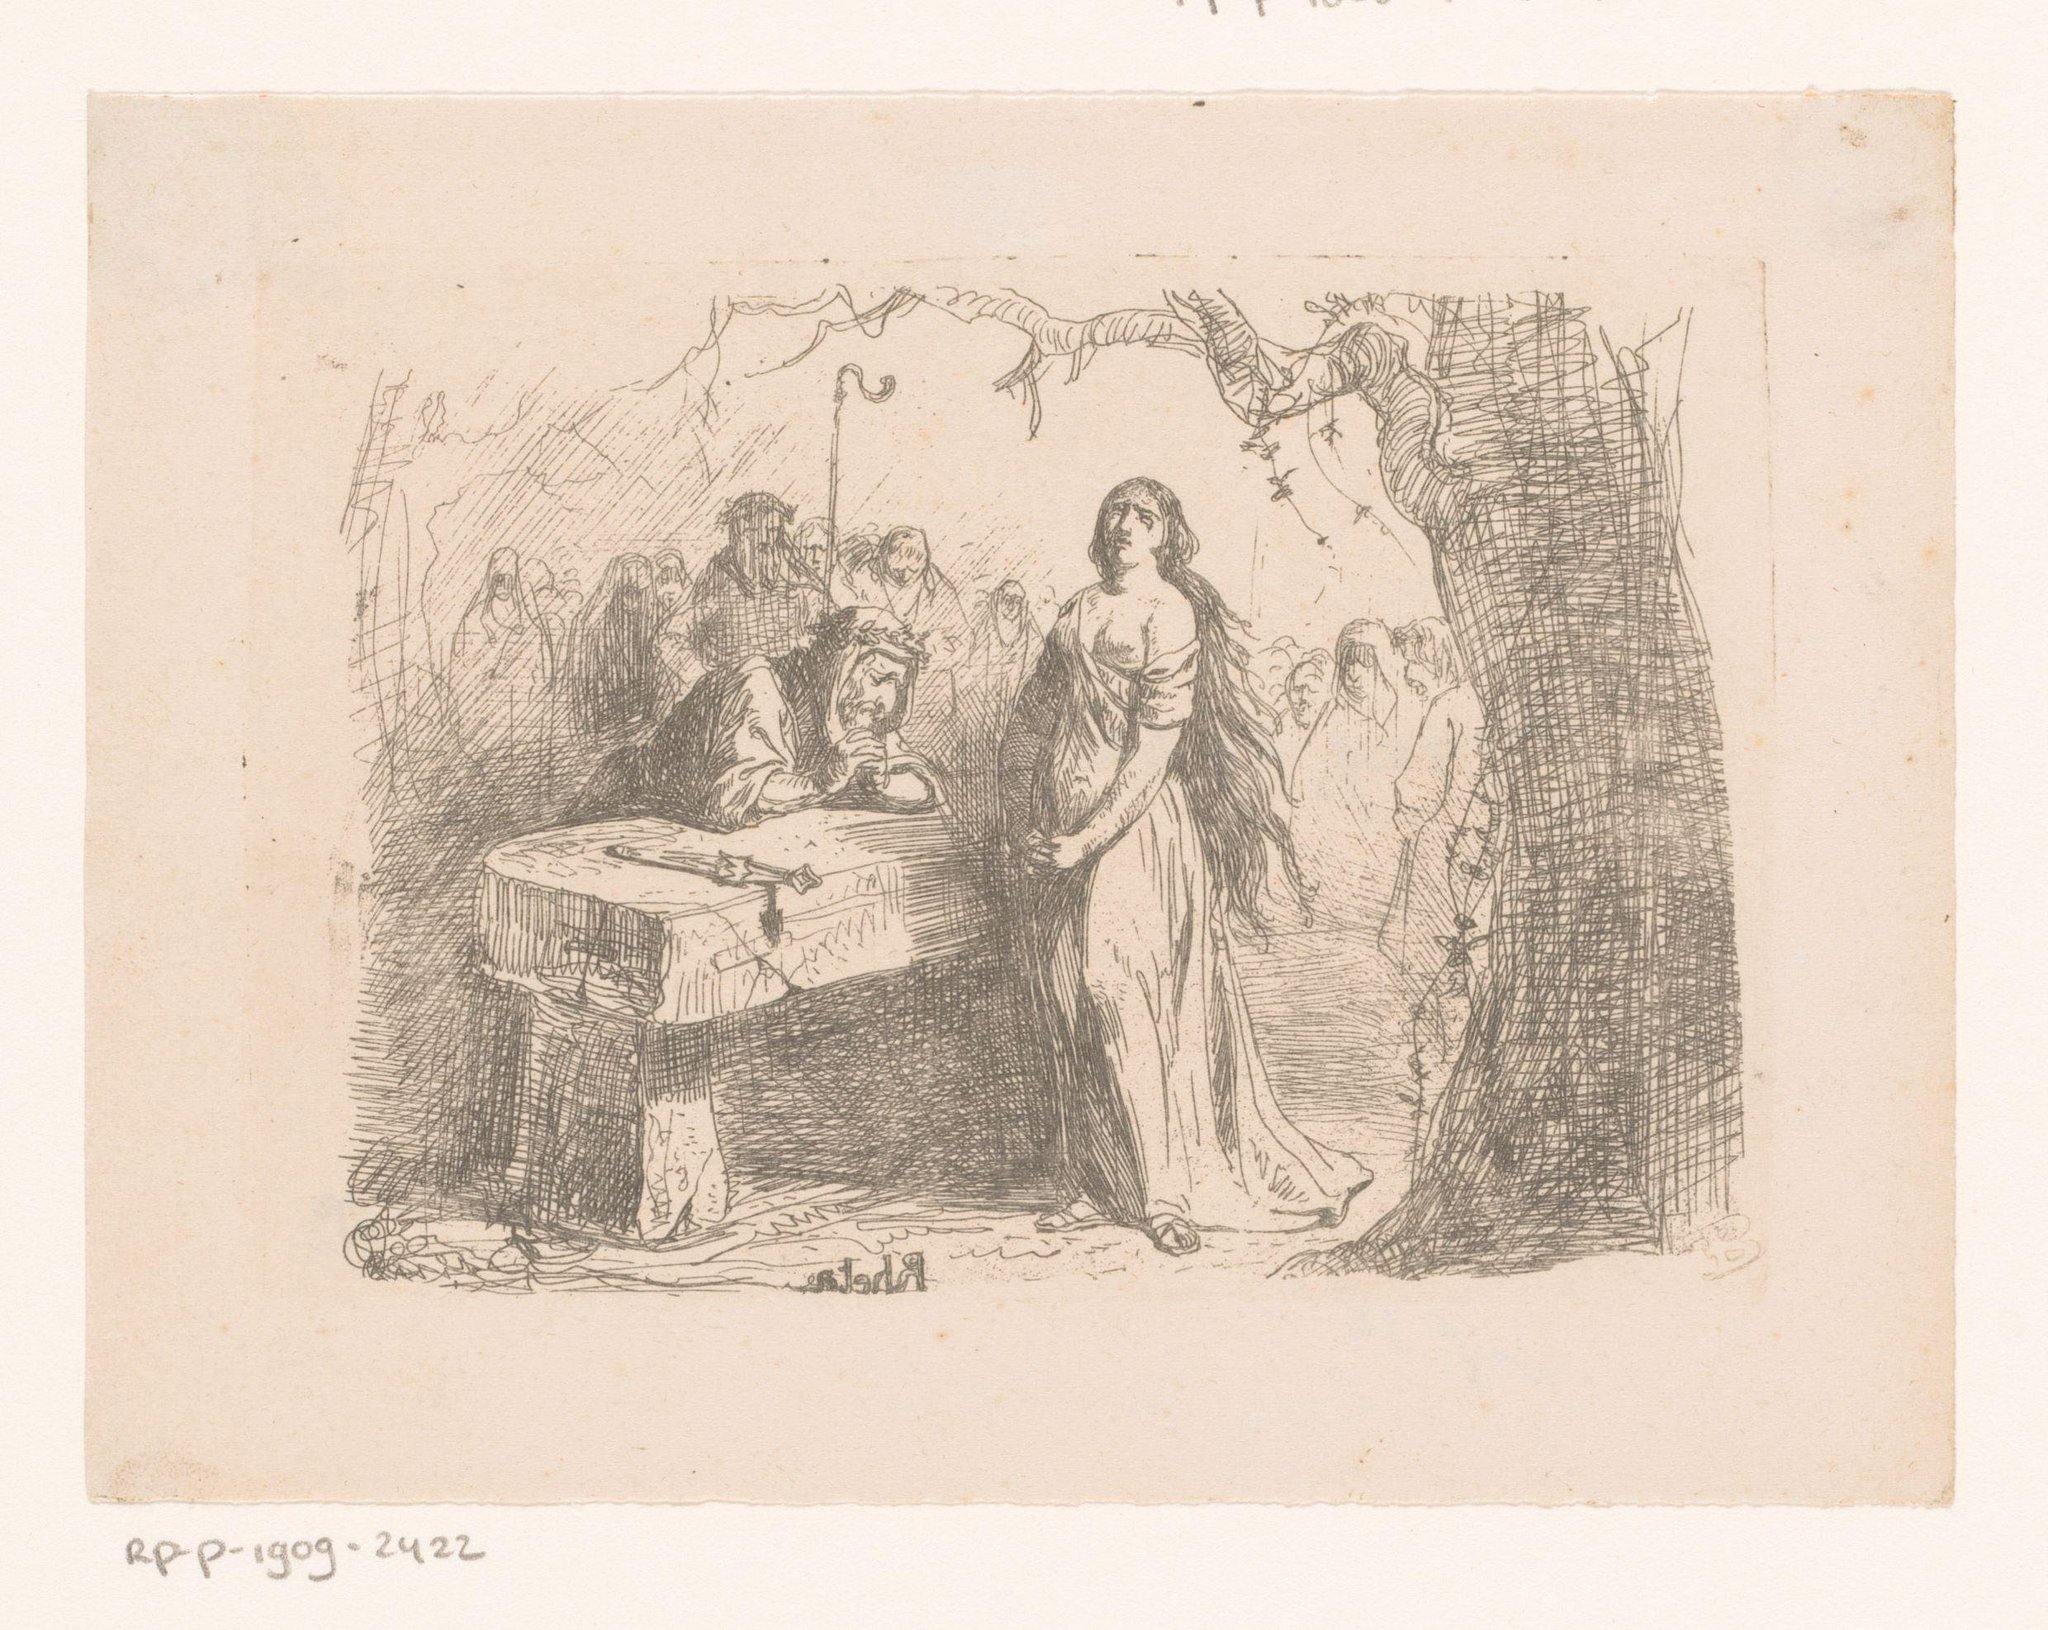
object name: print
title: Jonge vrouw te midden van druïden bij een offertafel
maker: eugène françois de block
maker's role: draughtsman, painter, print maker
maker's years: 1812-1893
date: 1842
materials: paper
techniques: printmaking, etching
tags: adult woman, human sacrifice ~ non-christian religions, druid (celtic religious functionary)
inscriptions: collector's mark: Lugt 2228, collector's mark: Lugt 1485